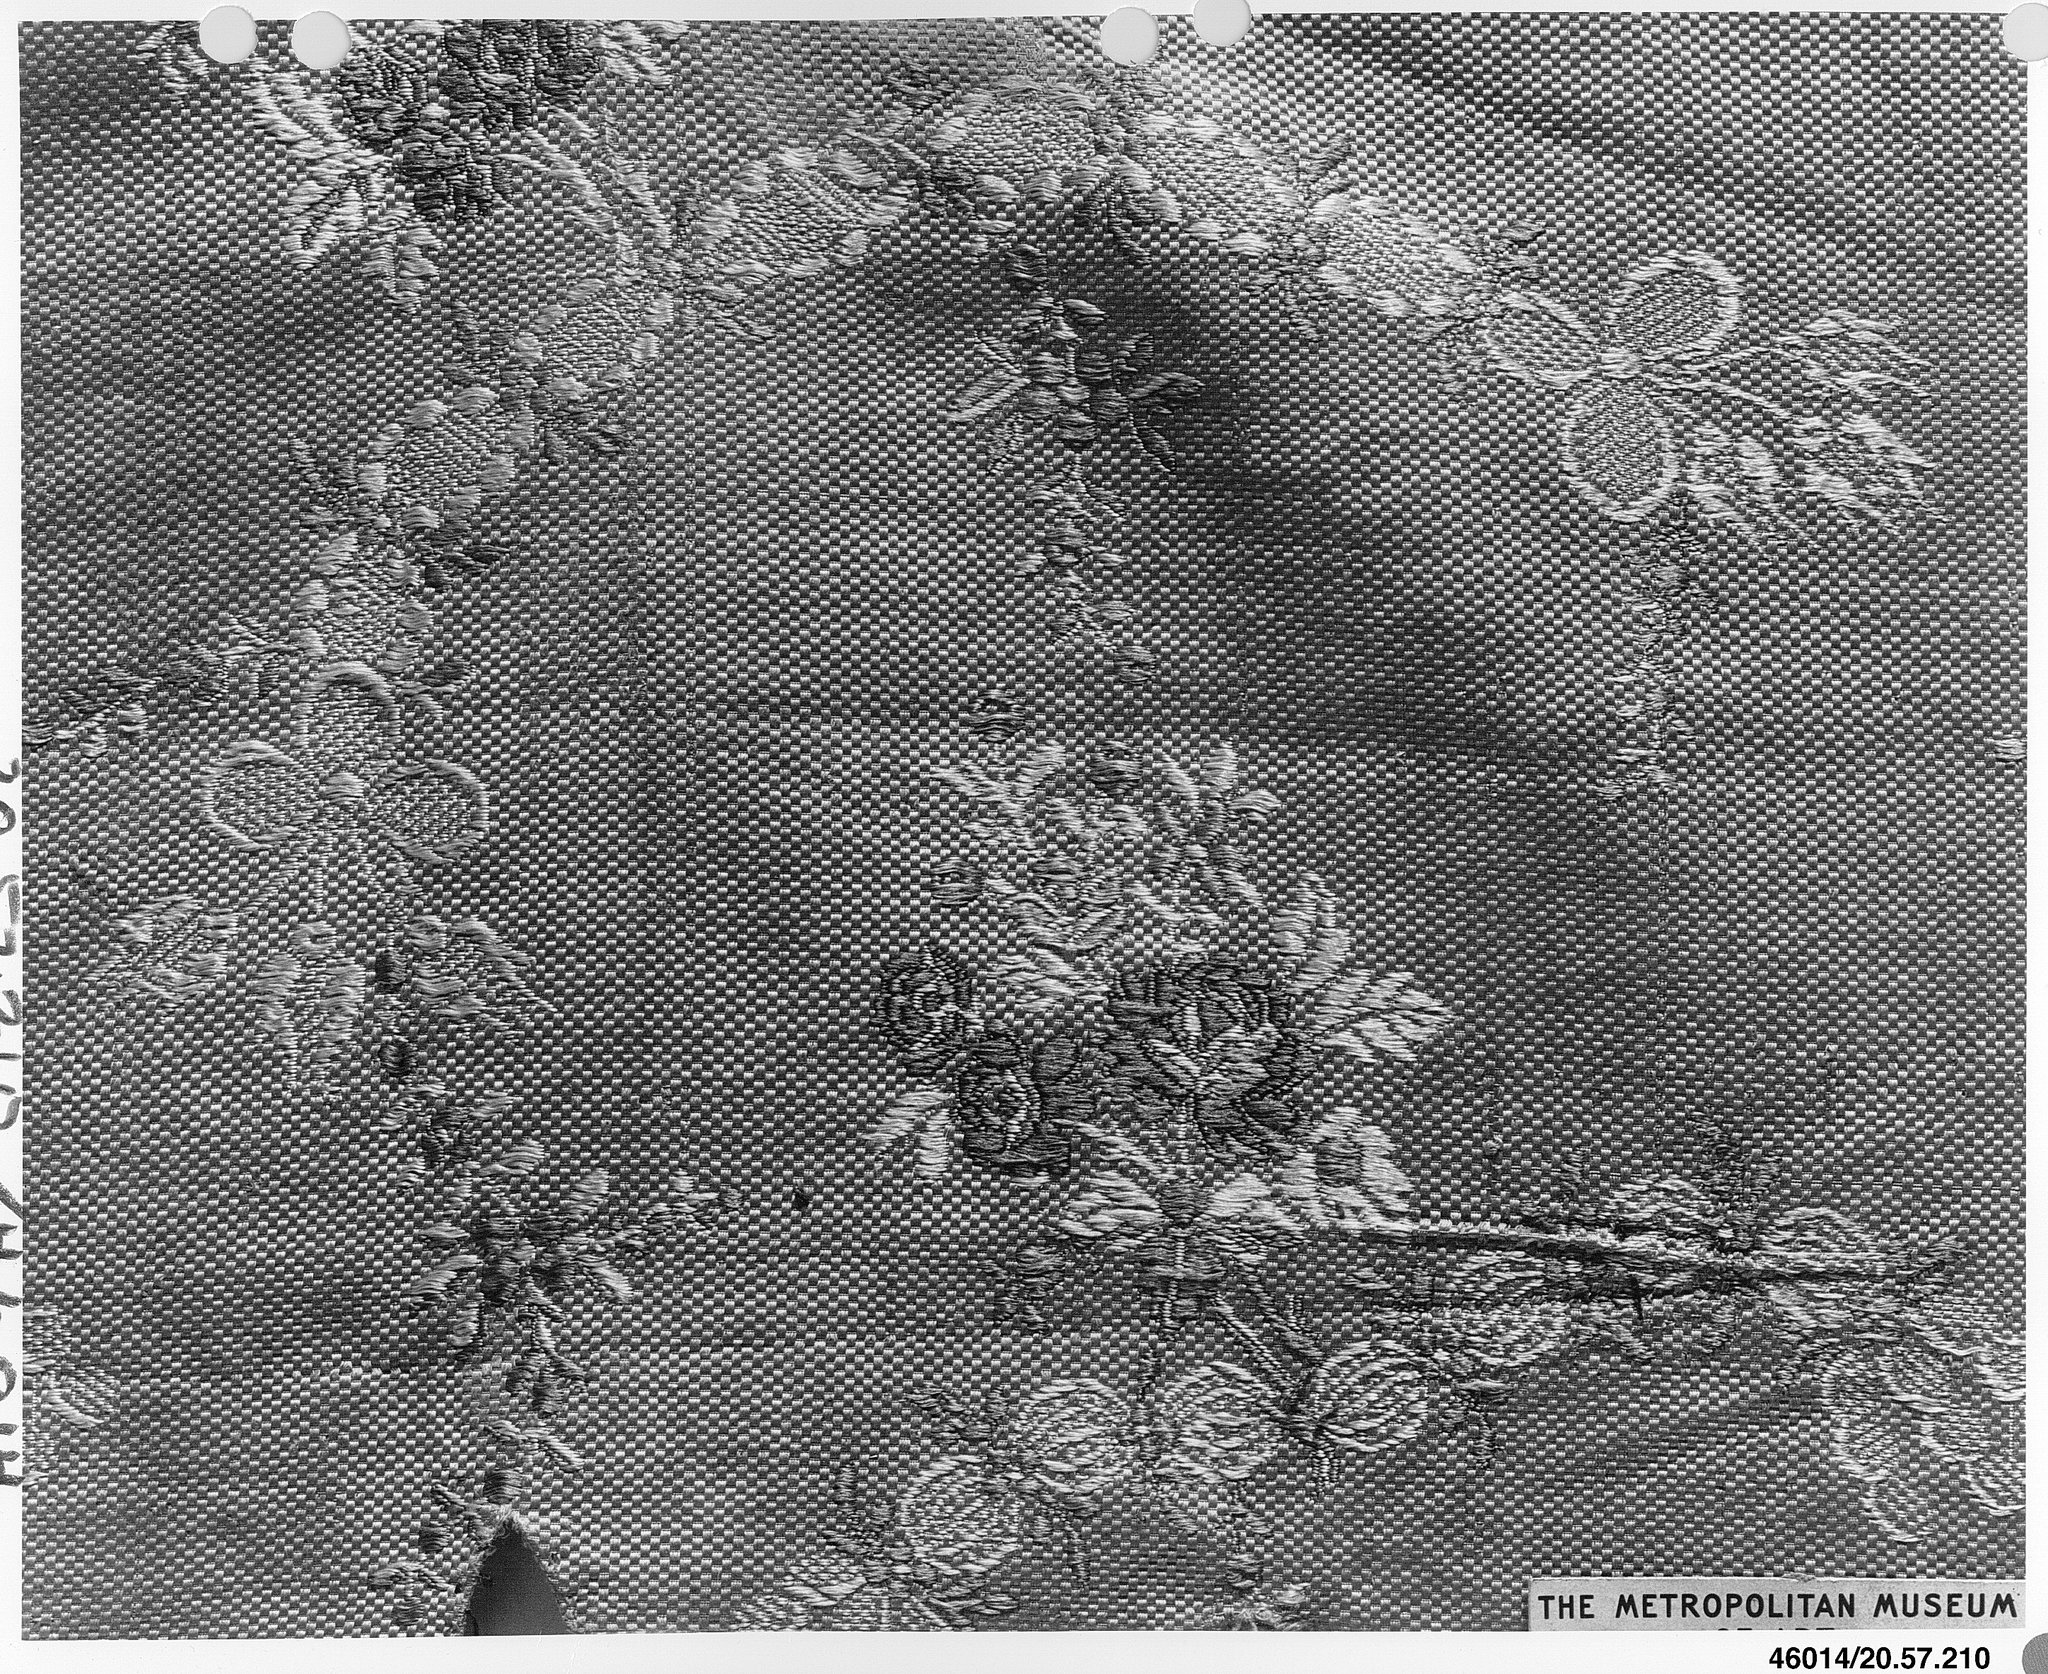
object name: piece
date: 1760-1770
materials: silk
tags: flowers,leaves